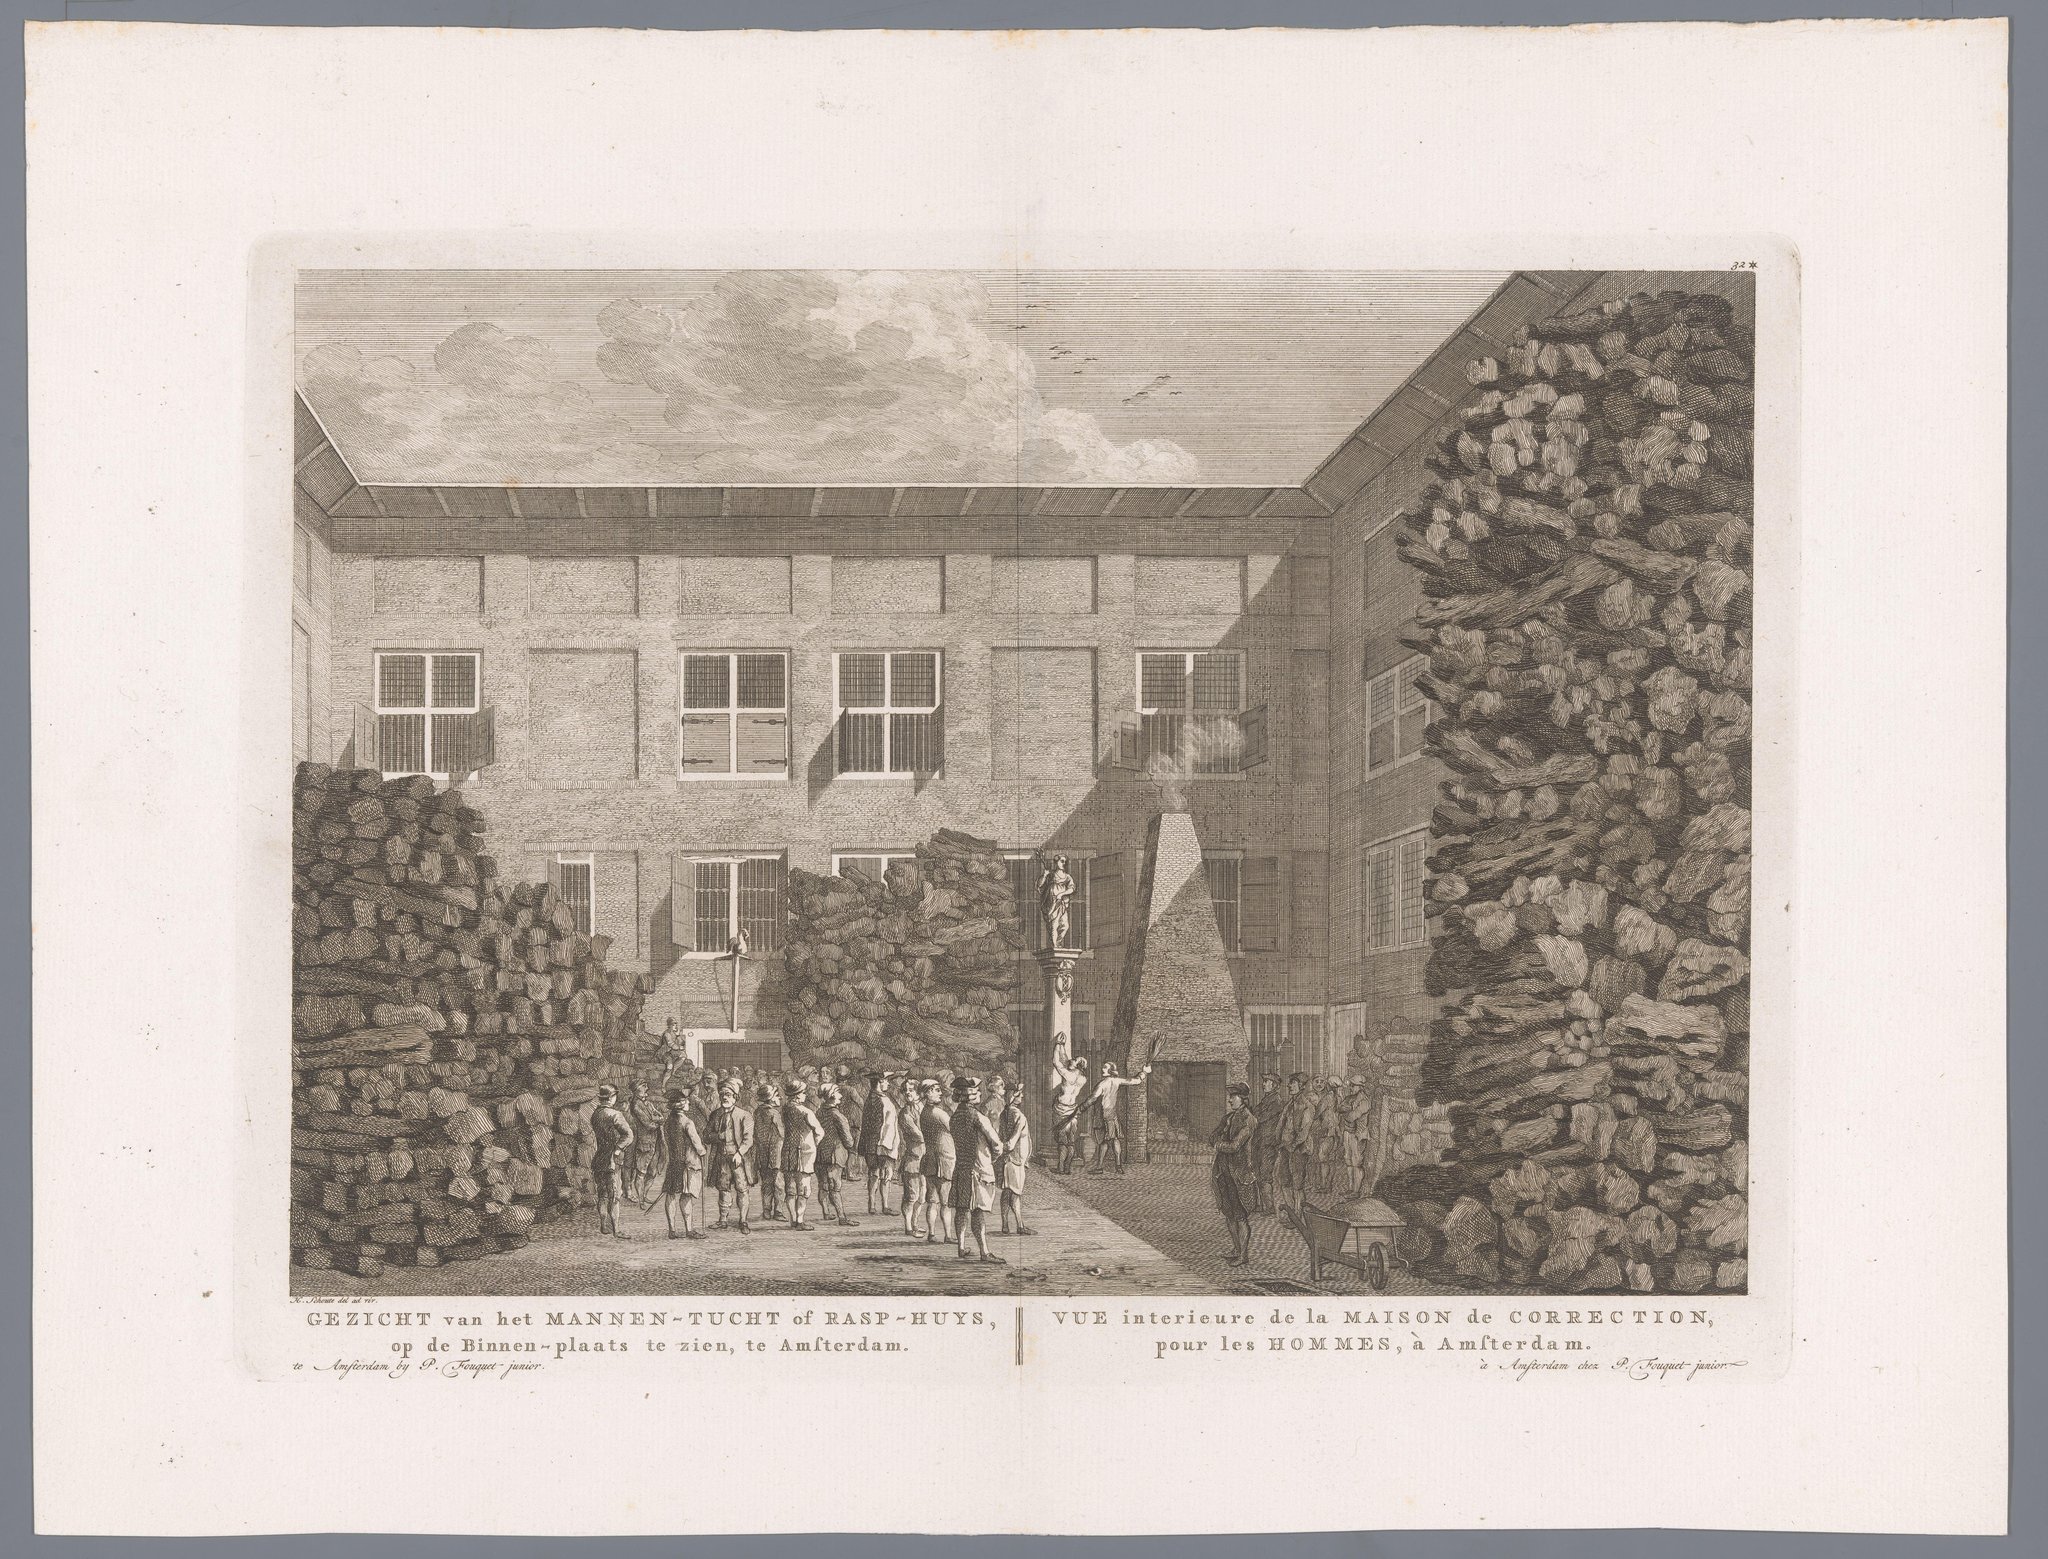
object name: print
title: Gezicht op de binnenplaats van het Rasphuis te Amsterdam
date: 1770-1783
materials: paper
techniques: etching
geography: amsterdam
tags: prison, jail, (prisoners) in the prison yard, workhouse, penal camp, penitentiary, chain gang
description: Vanaf 1760 gaf Pierre Fouquet stadsgezichten van Amsterdam naar tekeningen van verschillende kunstenaars uit. Deze prenten werden aanvankelijk los verkocht. Later werden ze samengebonden verkocht in verschillende volgordes en aantallen in: (1). Afbeeldingen van de wyd-vermaarde koopstad Amsterdam benevens des zelvs voornaamste gebouwen en gezigten alle naar het leeven getekend / Receuil des edifices les plus considerables et des plus belles vues, de la fameuse ville d'Amsterdam, dessinées d'après nature. Amsterdam: Pierre Fouquet, 1778-1783. Deze 'uitgave' bestond waarschijnlijk alleen uit een titelblad en inhoudsopgave van de tot dusver 100 uitgegeven prenten, die de koper zelf aan zijn of haar reeds verzamelde prenten kon toevoegen. De hoeveelheid en volgorde van prenten verzameld onder deze titel verschilt dus sterk. (2). Nieuwe atlas, van de voornaamste gebouwen en gezigten der stad Amsterdam, met derzelver beknopte beschryvingen. 2 dln. Amsterdam: Daniël Jean Changuion en Petrus den Hengst [in opdracht van Pierre Fouquet], 1783. Ook werden er door verschillende uitgevers tussen 1788 (Amsterdam: Petrus Conradi) en 1805 (Amsterdam: Evert Maaskamp) heruitgaven gepubliceerd.